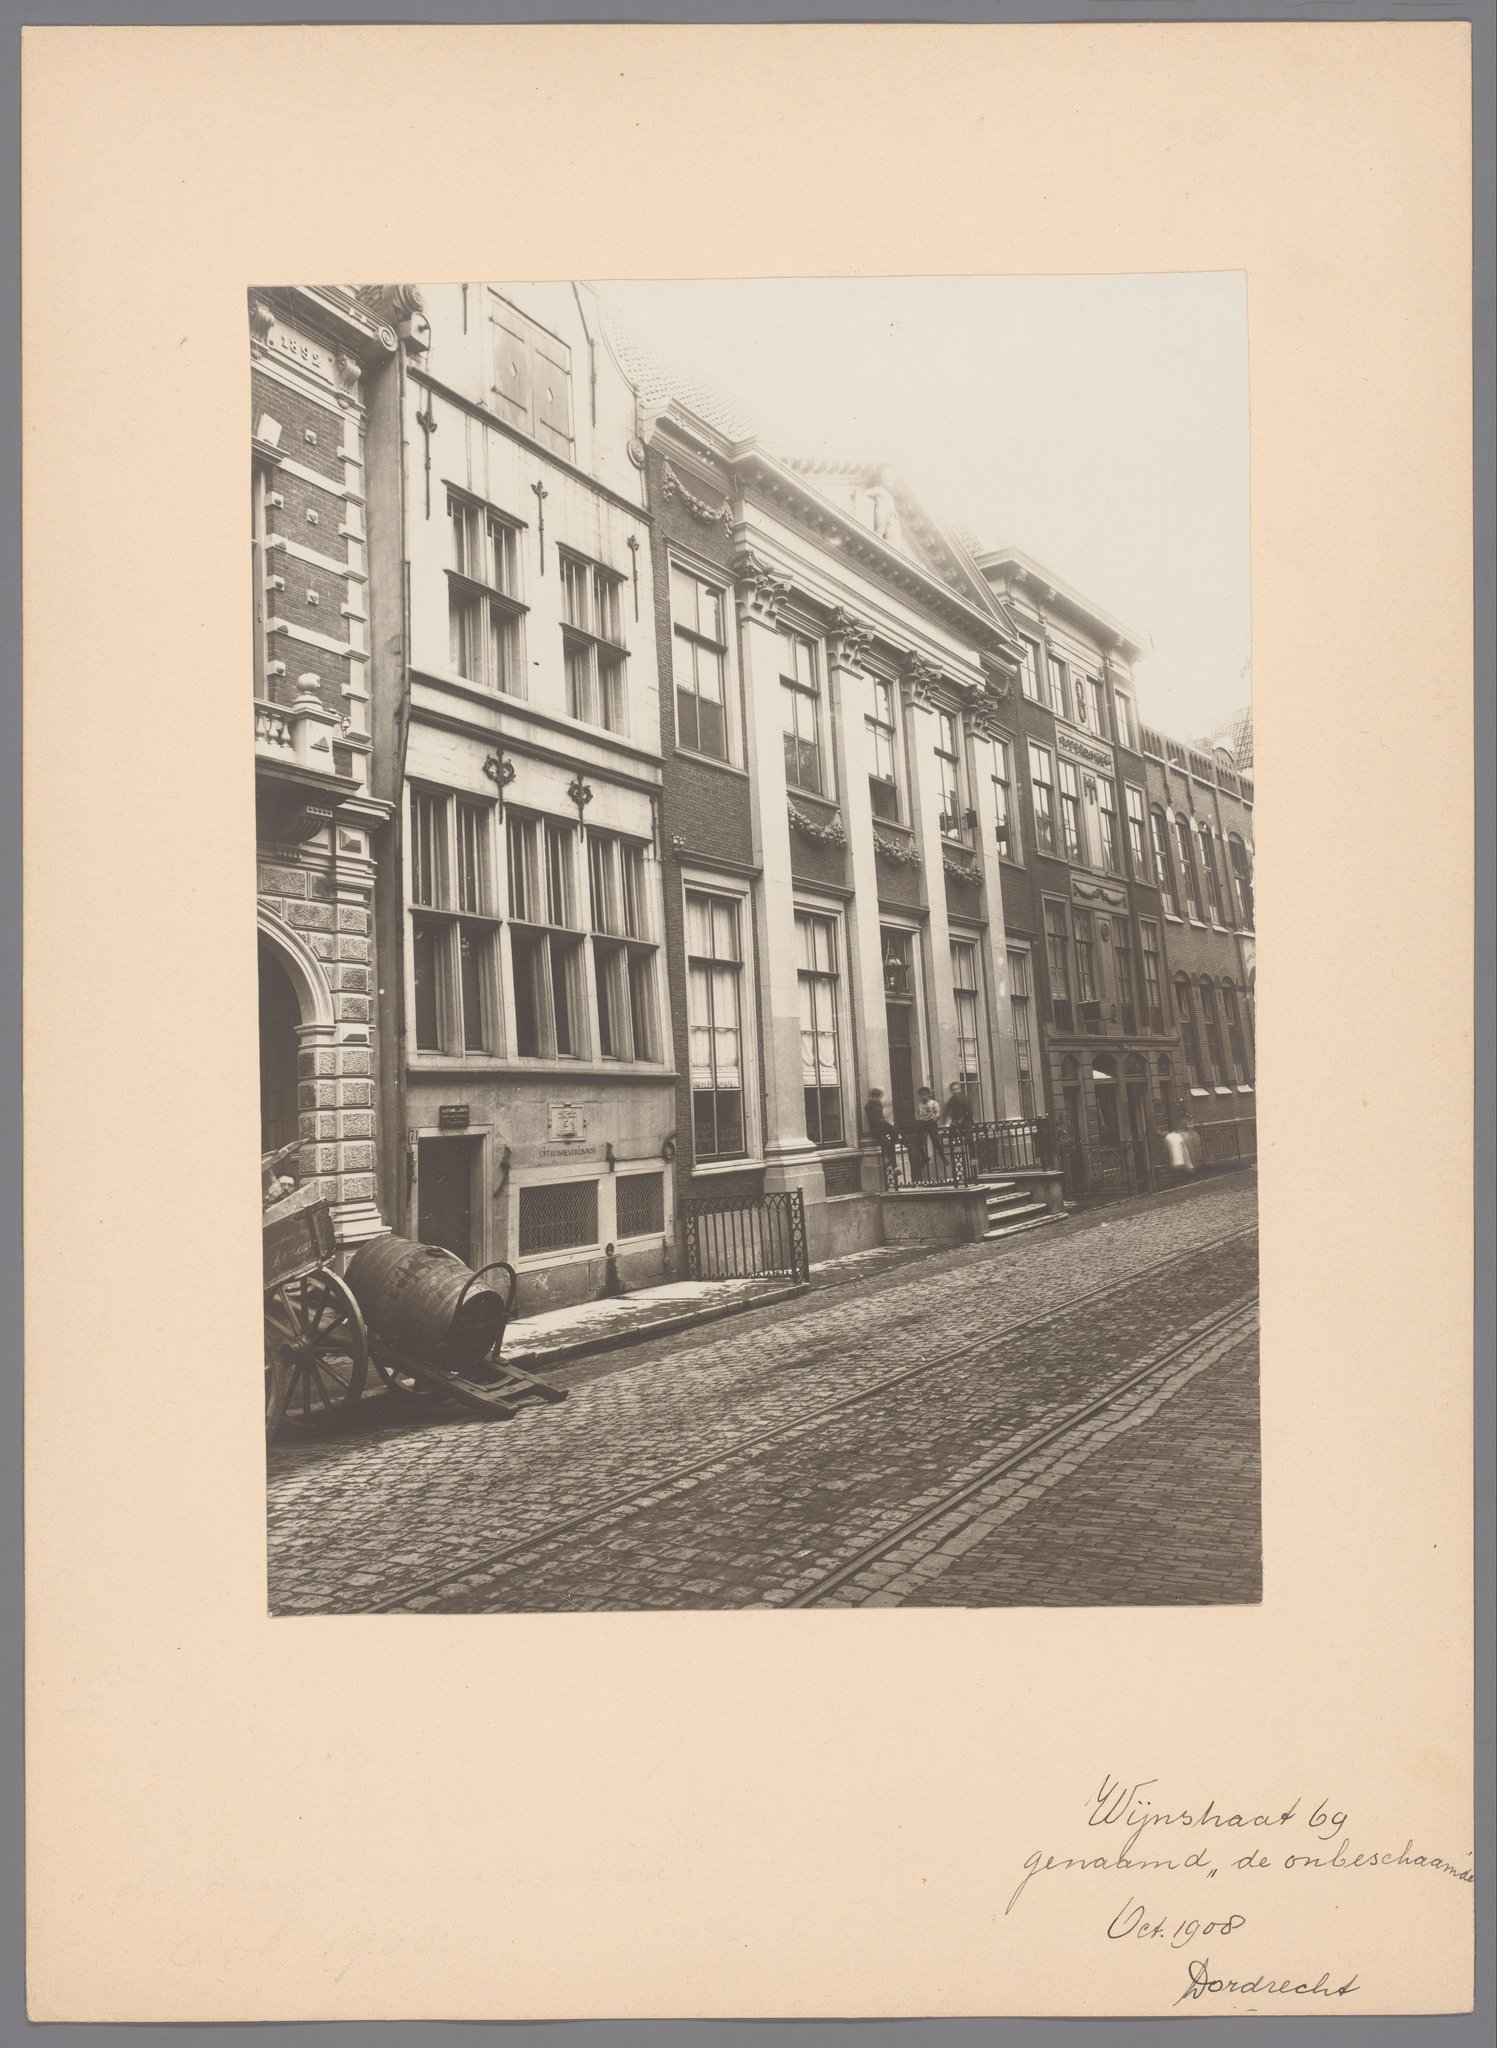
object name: photograph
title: Pand op Wijnstraat 69 te Dordrecht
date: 1908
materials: cardboard, photographic support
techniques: gelatin silver print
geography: wijnstraat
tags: urban housing, façade (of house or building)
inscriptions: annotation: ‘Wijnstraat 69/ genaamd "de onbeschaamde"/ Oct. 1908/ Dordrecht’